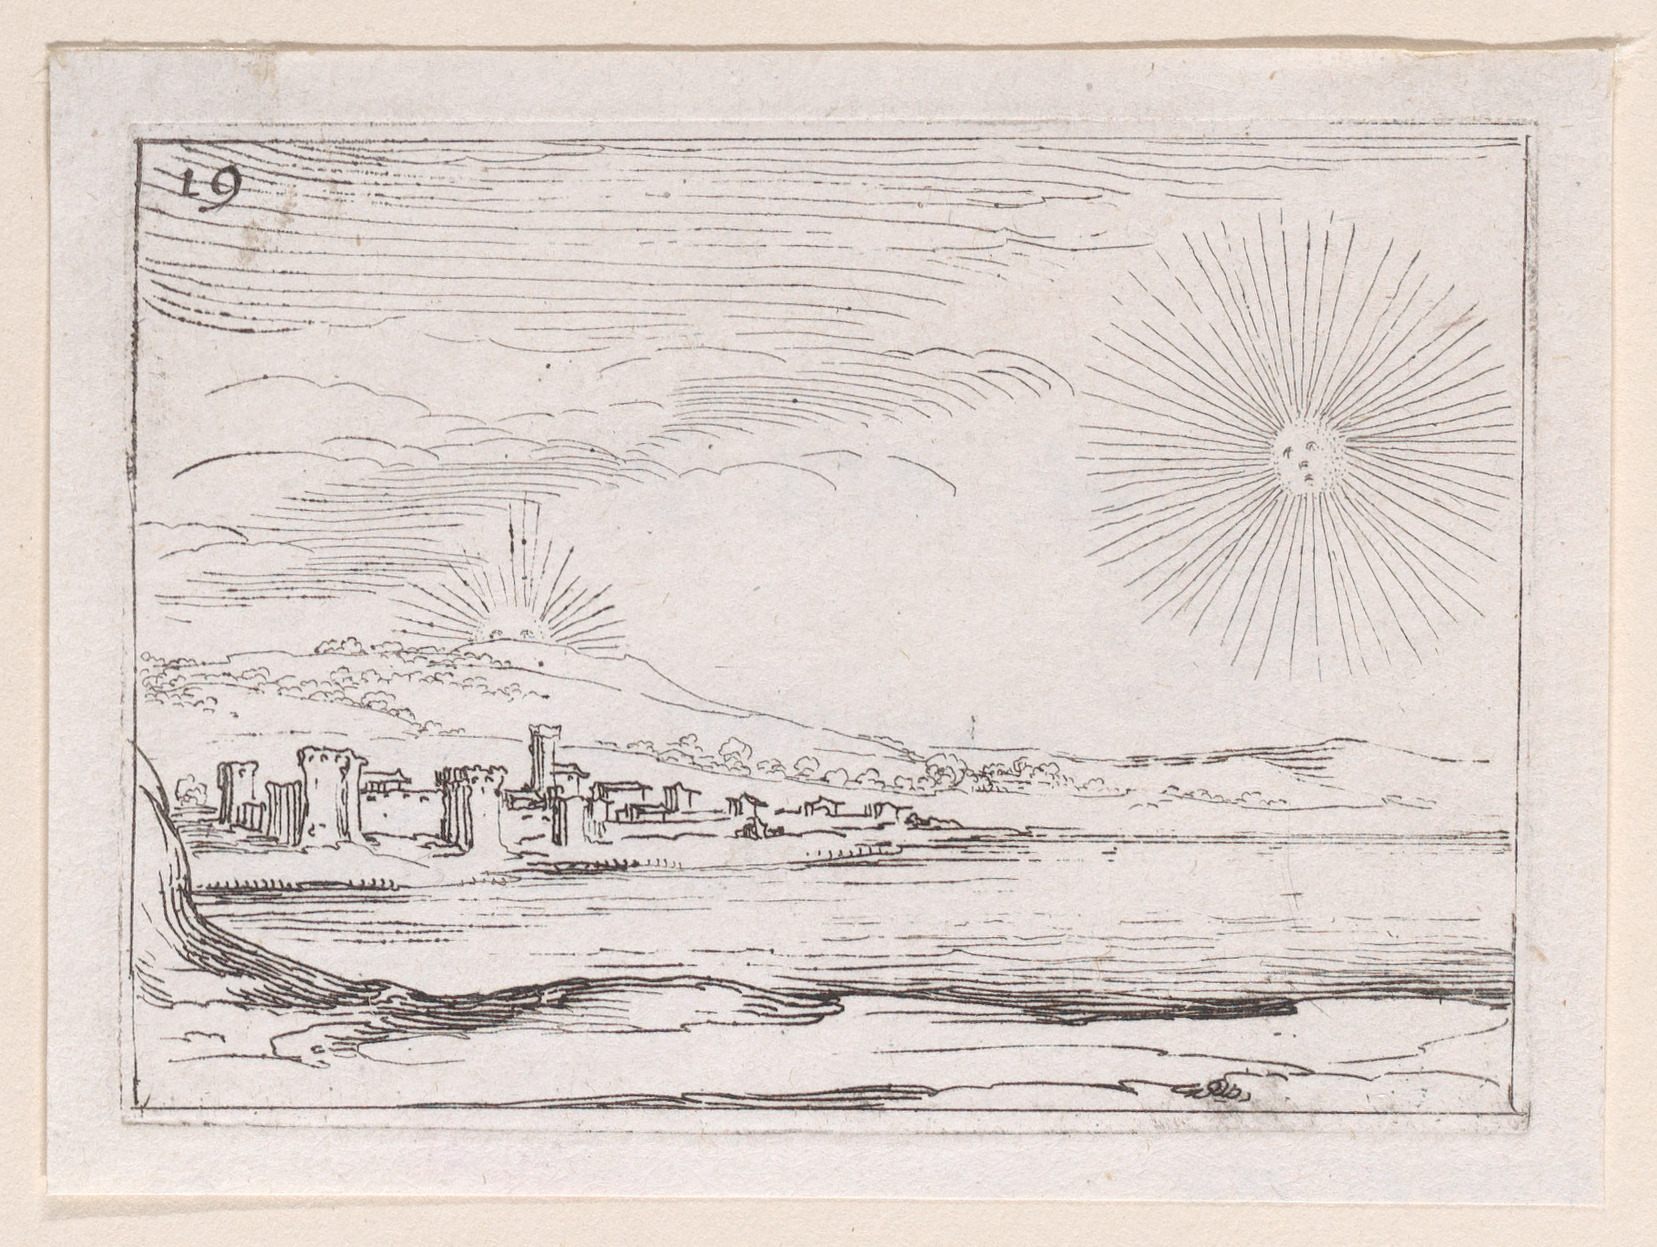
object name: print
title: Le Soleil Levant (The Sun Rising), plate 19 from "Lux Claustri ou La Lumière du Cloitre" (The Light of the Cloisters)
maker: jacques callot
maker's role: artist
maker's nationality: french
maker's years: 1592-1635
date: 1621-1635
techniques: etching